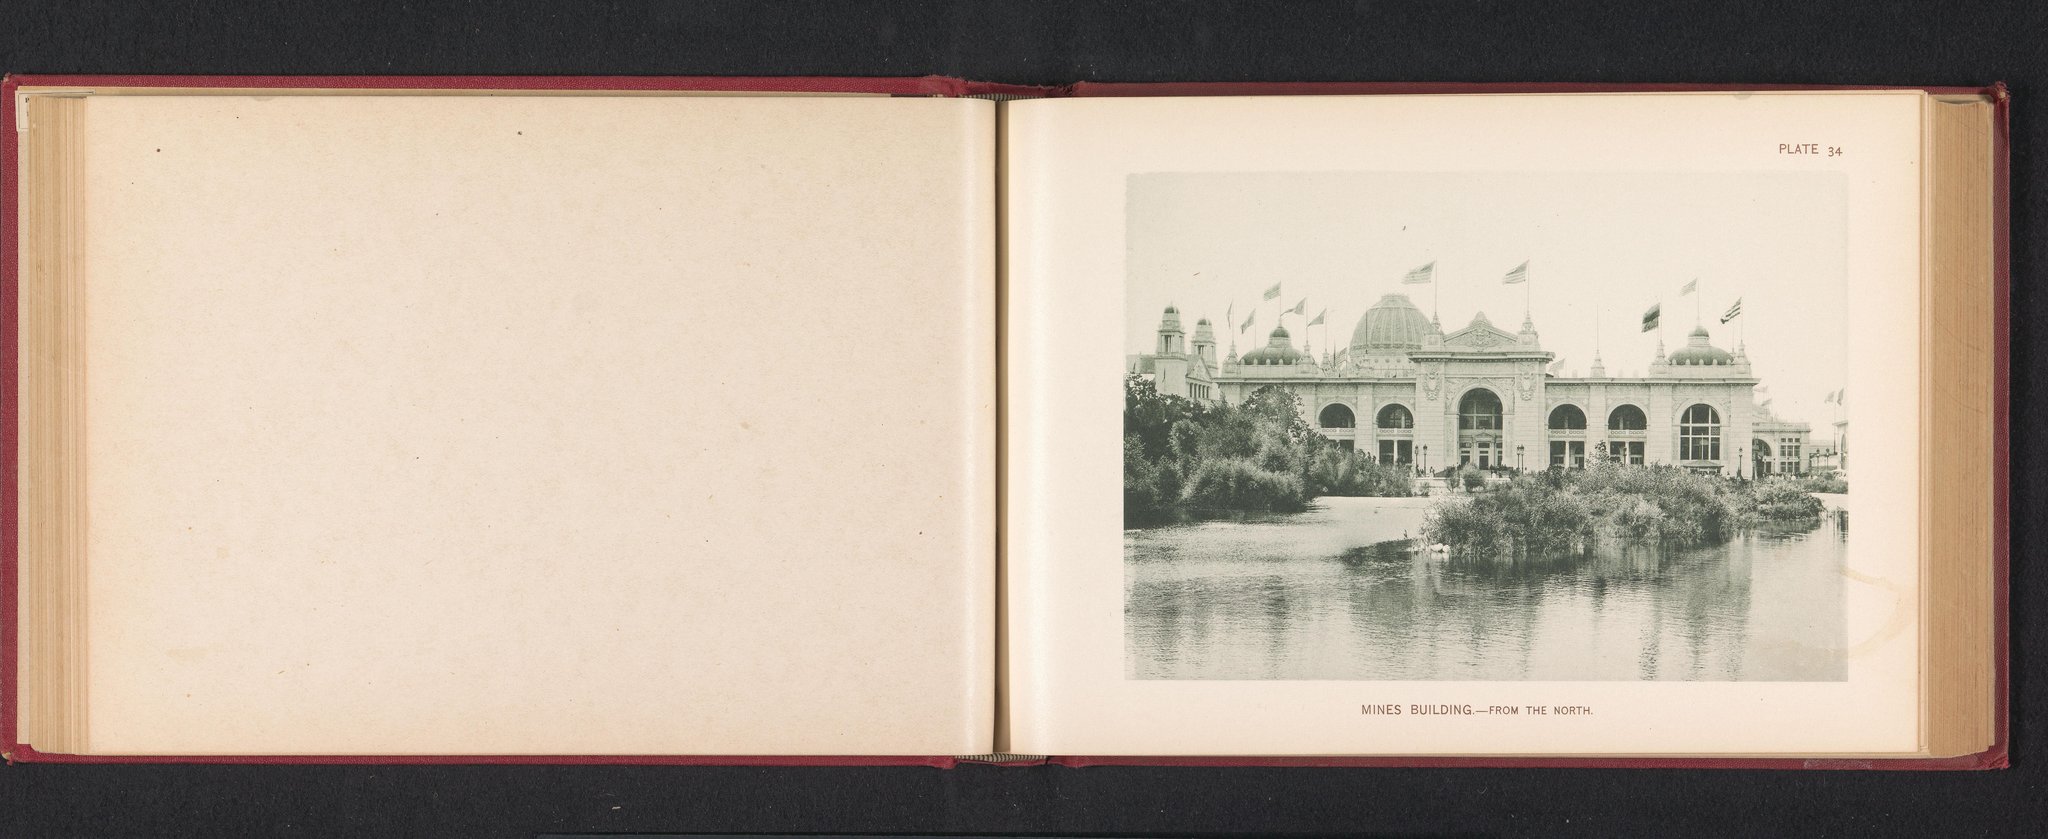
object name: page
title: Gezicht op het gebouw voor mijnen en mijnbouw, ontworpen door Solon Spencer Beman op de World's Columbian Exposition in Chicago in 1893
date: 1893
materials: paper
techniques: photograph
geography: chicago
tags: world fair, world exhibition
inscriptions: number: ‘Plate 34’